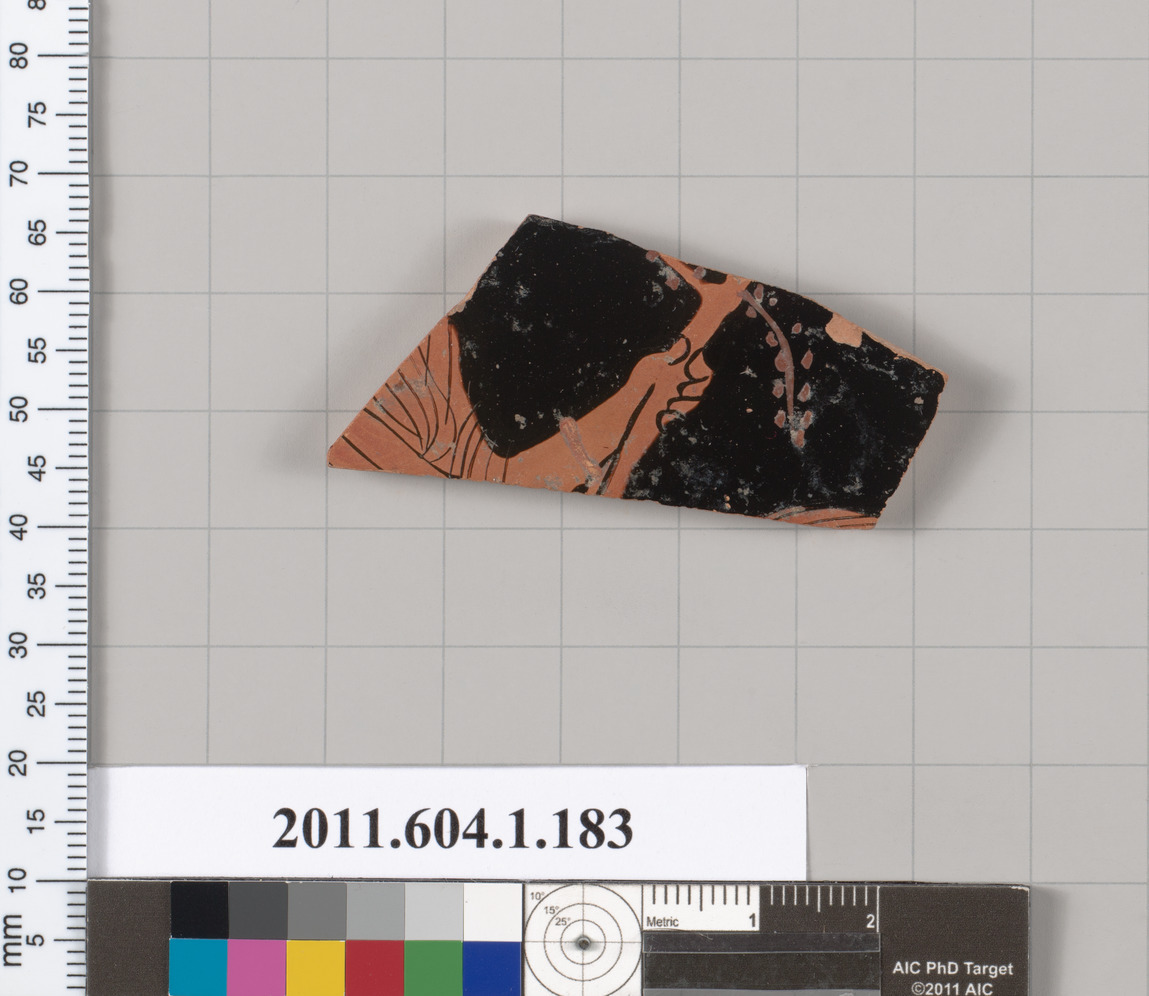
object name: kylix fragment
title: Terracotta fragment of a kylix (drinking cup)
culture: greek, attic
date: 475-451 BCE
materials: terracotta